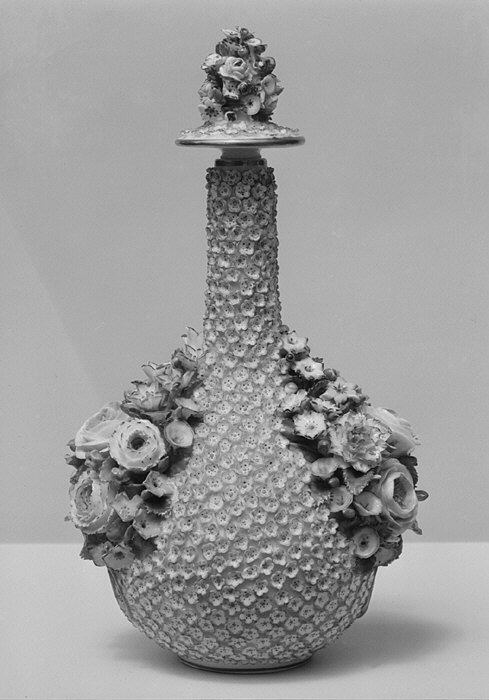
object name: vase with stopper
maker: fontainebleau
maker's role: factory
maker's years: 1530-1700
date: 1830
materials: hard paste porcelain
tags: flowers